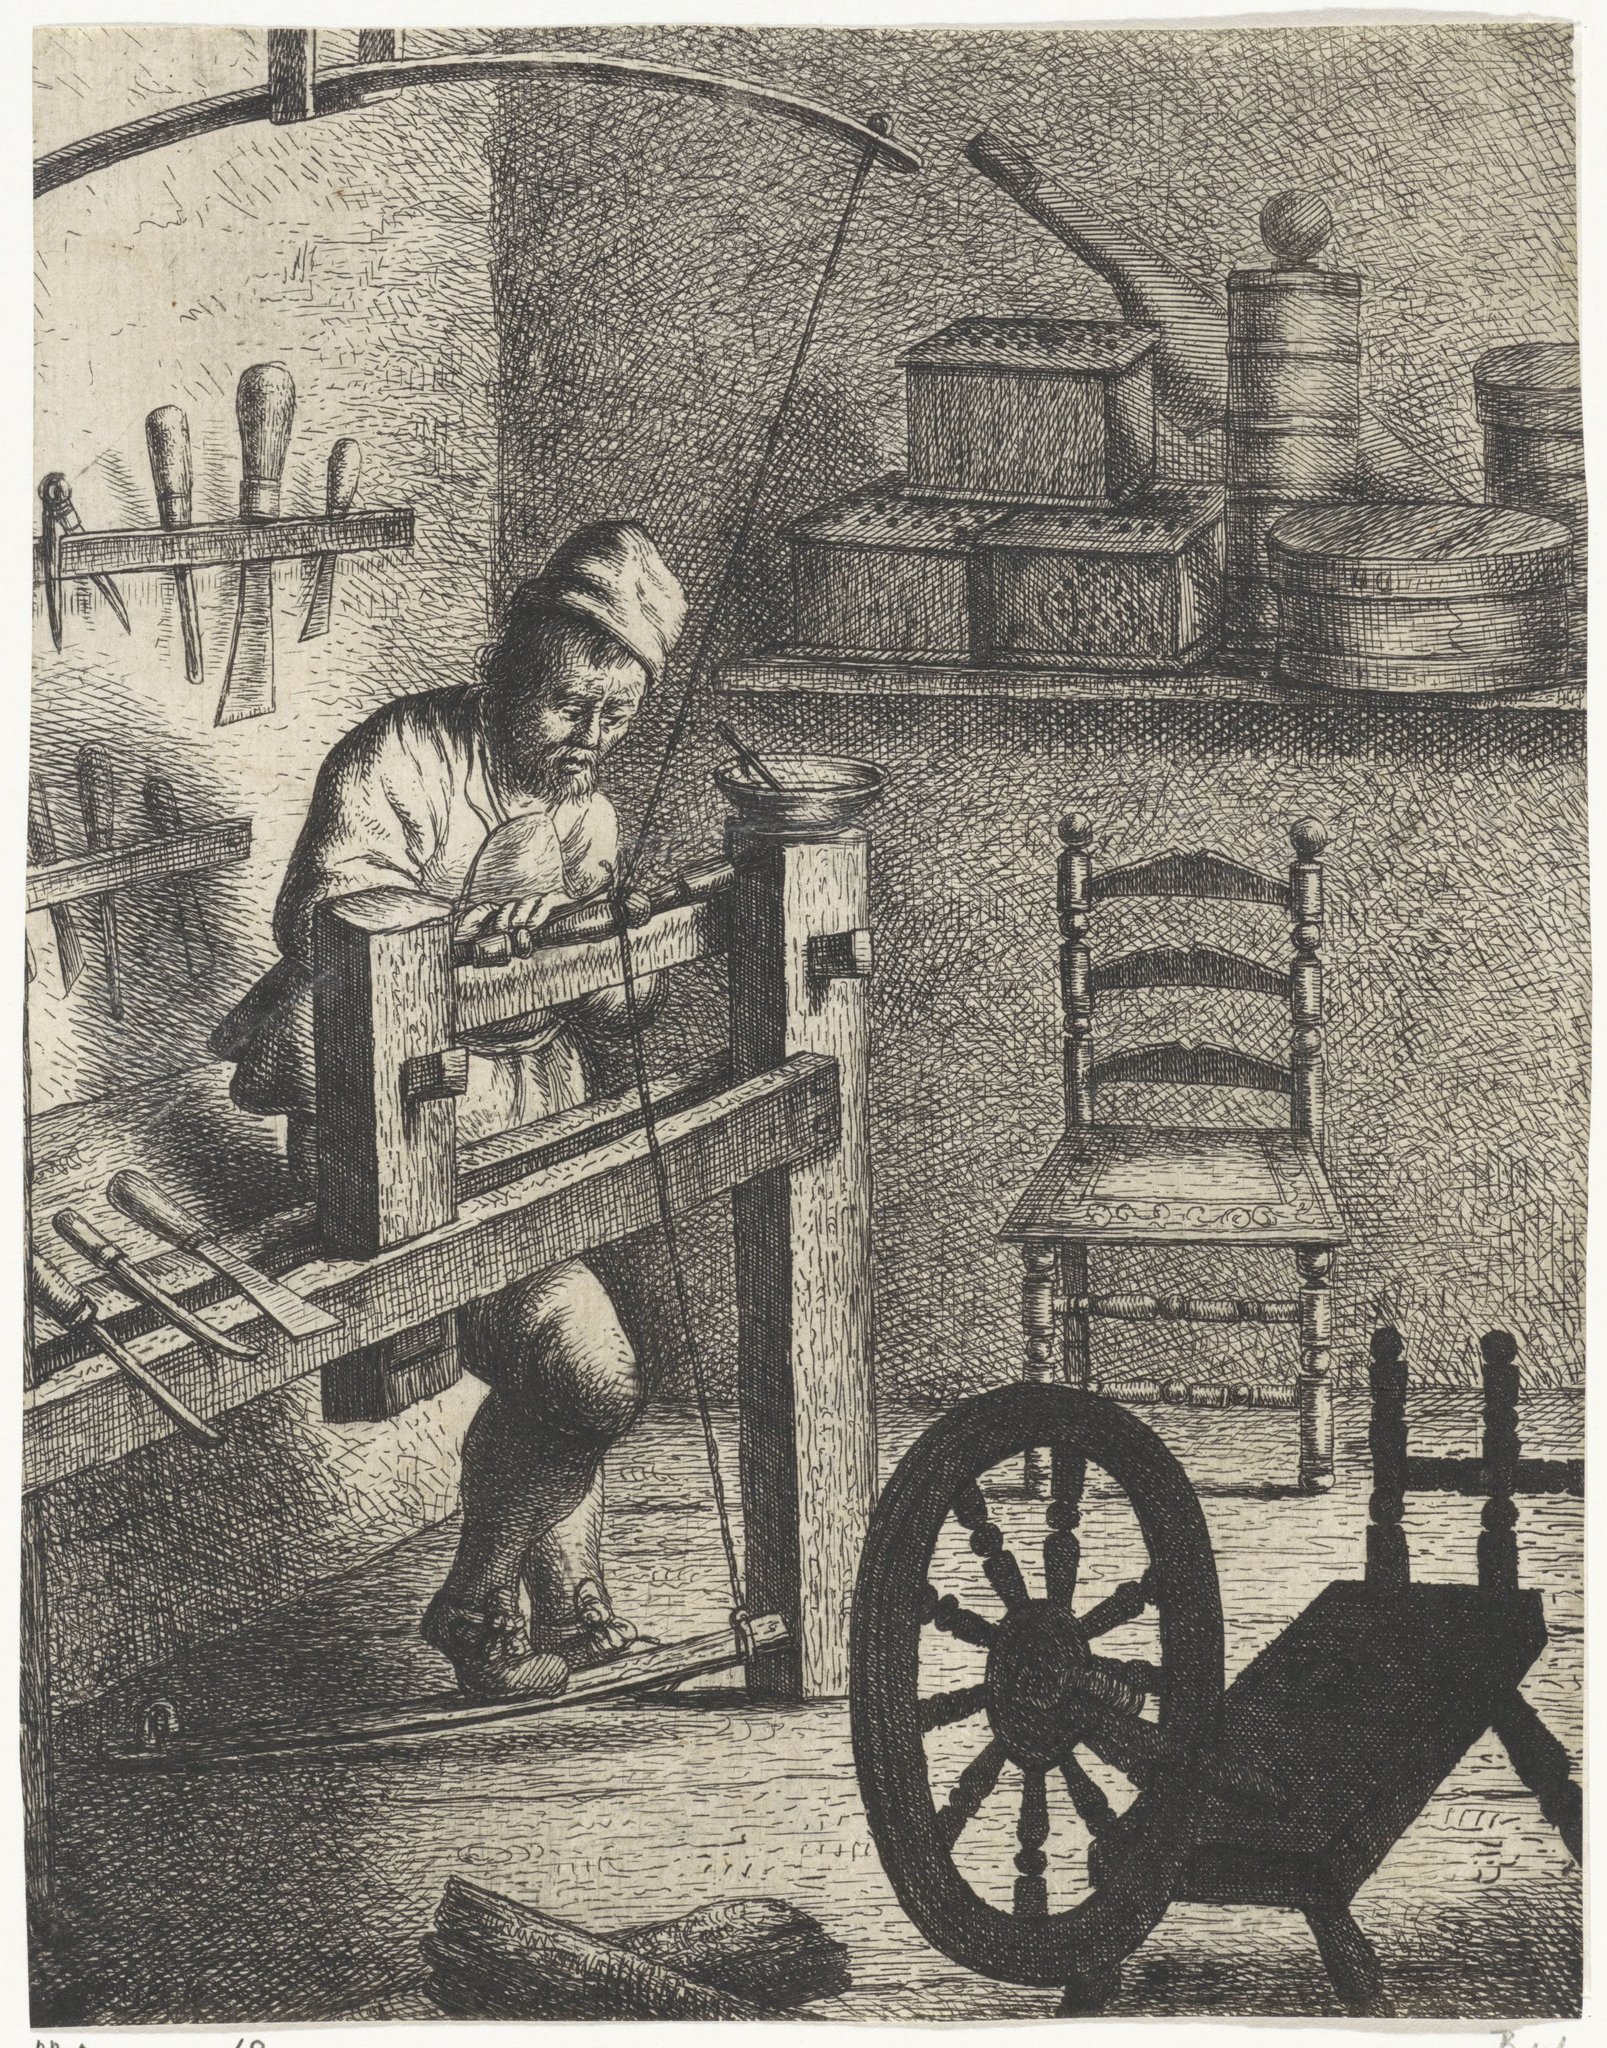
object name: print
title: Beroepen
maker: jan gillisz. van vliet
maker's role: draughtsman, painter, print maker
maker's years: 1600-1668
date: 1635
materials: paper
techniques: etching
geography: leiden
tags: turner in wood, tools, aids, implements ~ crafts and industries: chisel, spinning-wheel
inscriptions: collector's mark: Lugt 2228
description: Een man achter een draaibank. Aan de achterwand beitels. Op de voorgrond een spinnenwiel.